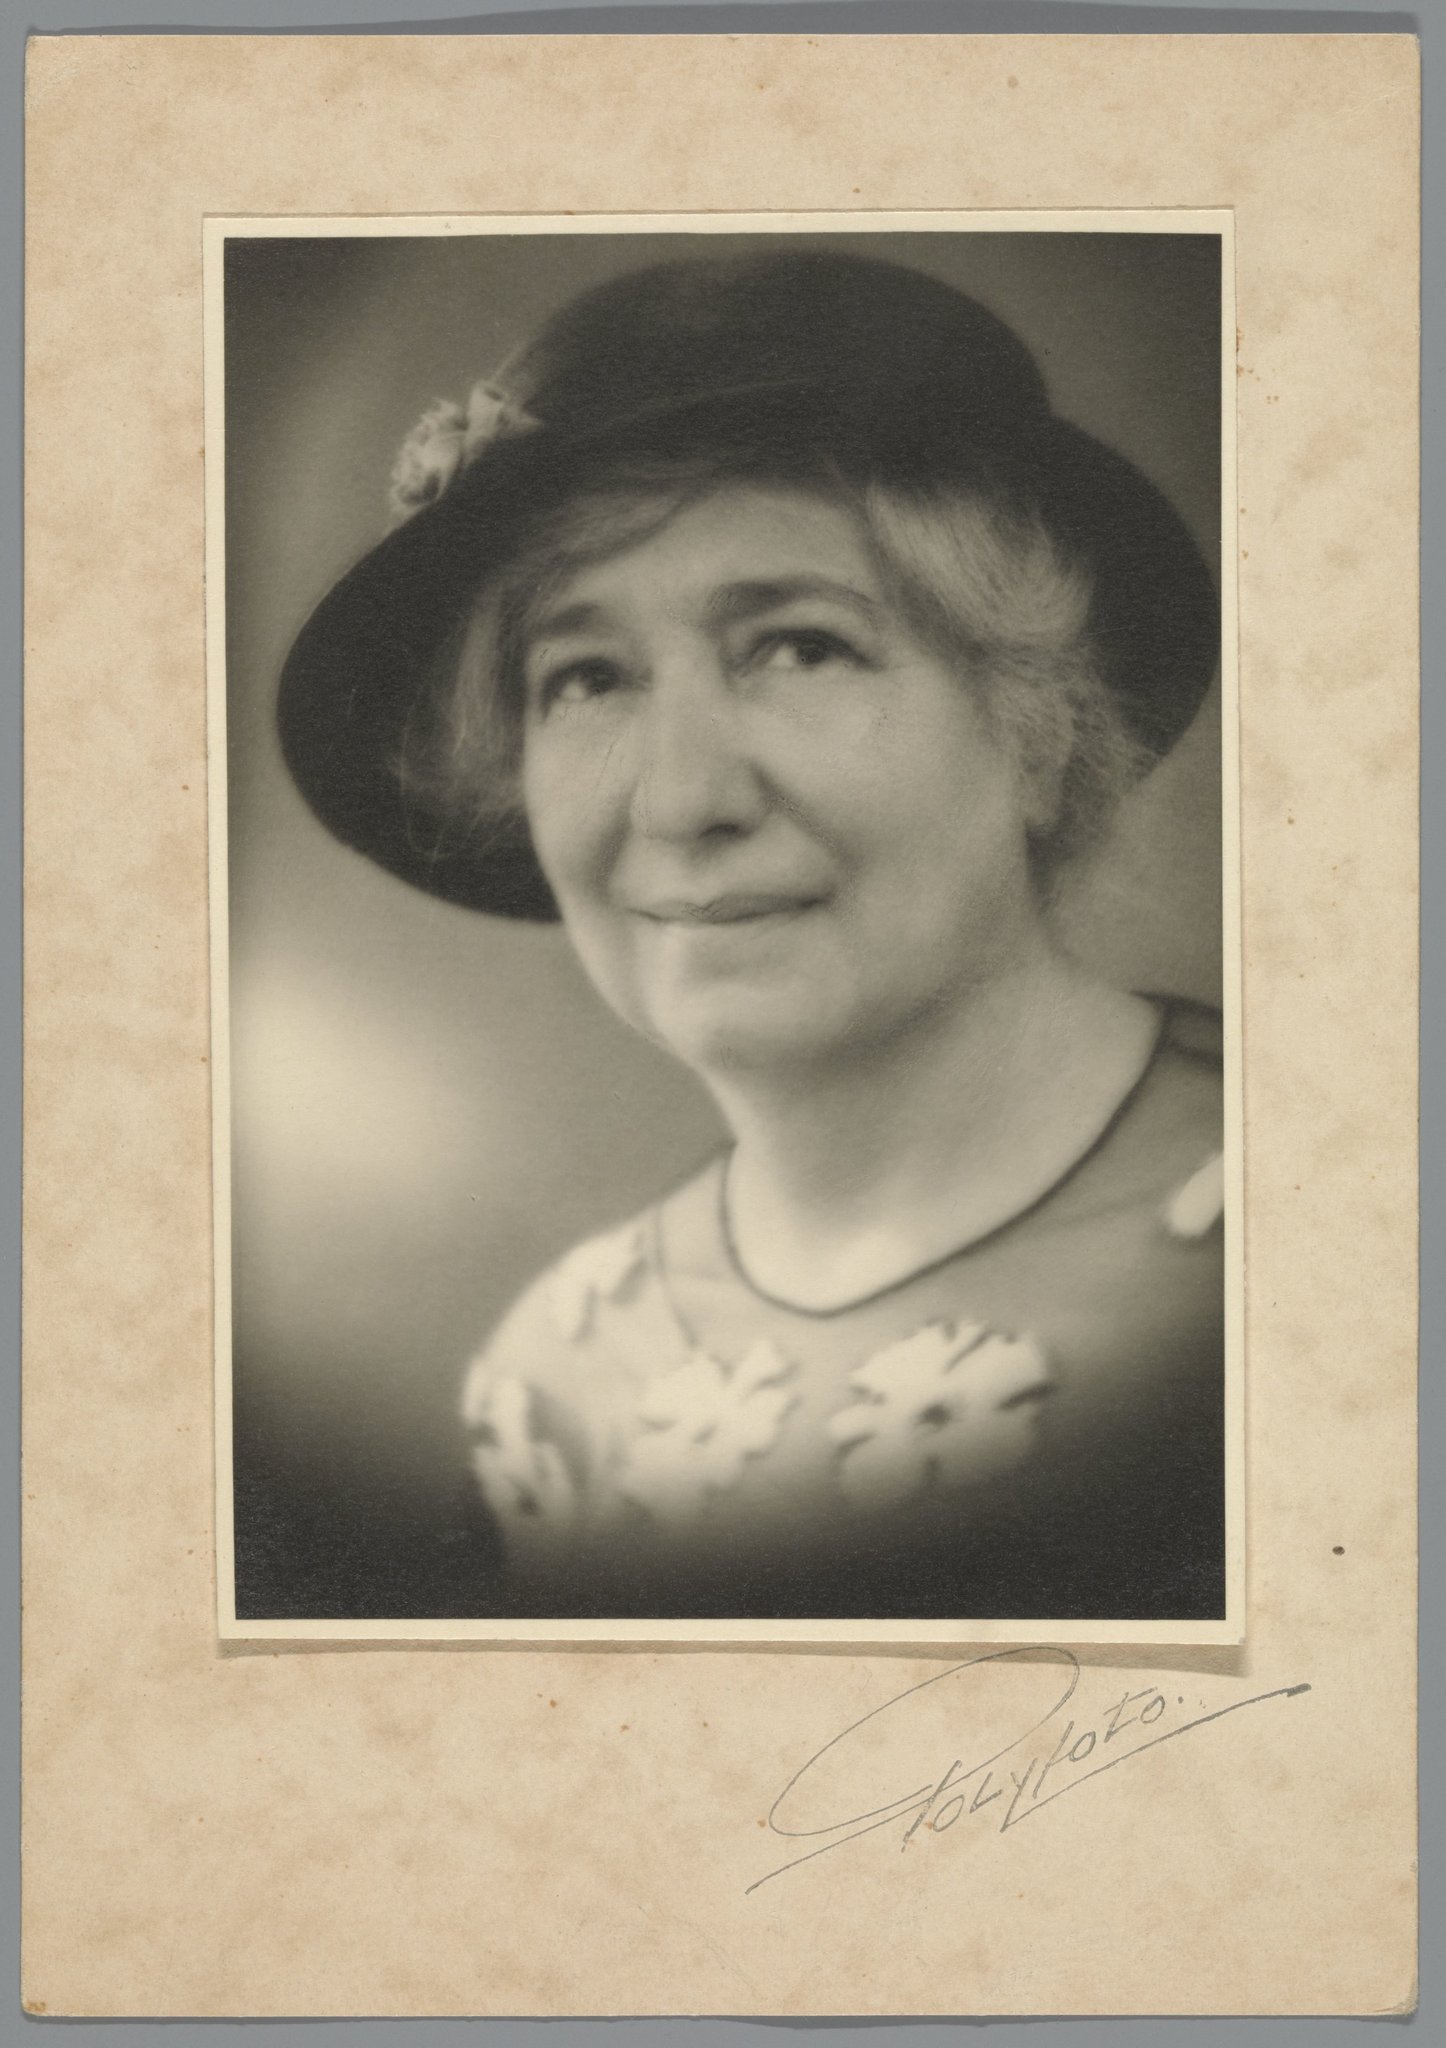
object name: photograph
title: Marie Witsen-Schorr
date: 1860-1915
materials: paper, photographic support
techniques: gelatin silver print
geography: netherlands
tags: augusta maria agnes witsen-schorr